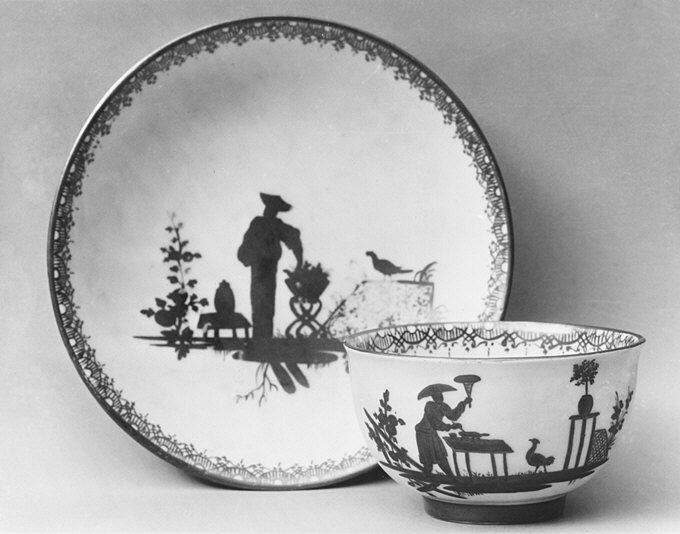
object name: cup and saucer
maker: meissen manufactory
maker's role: manufactory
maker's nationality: german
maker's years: 1710-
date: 1734-1766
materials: hard paste porcelain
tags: human figures,birds,plants